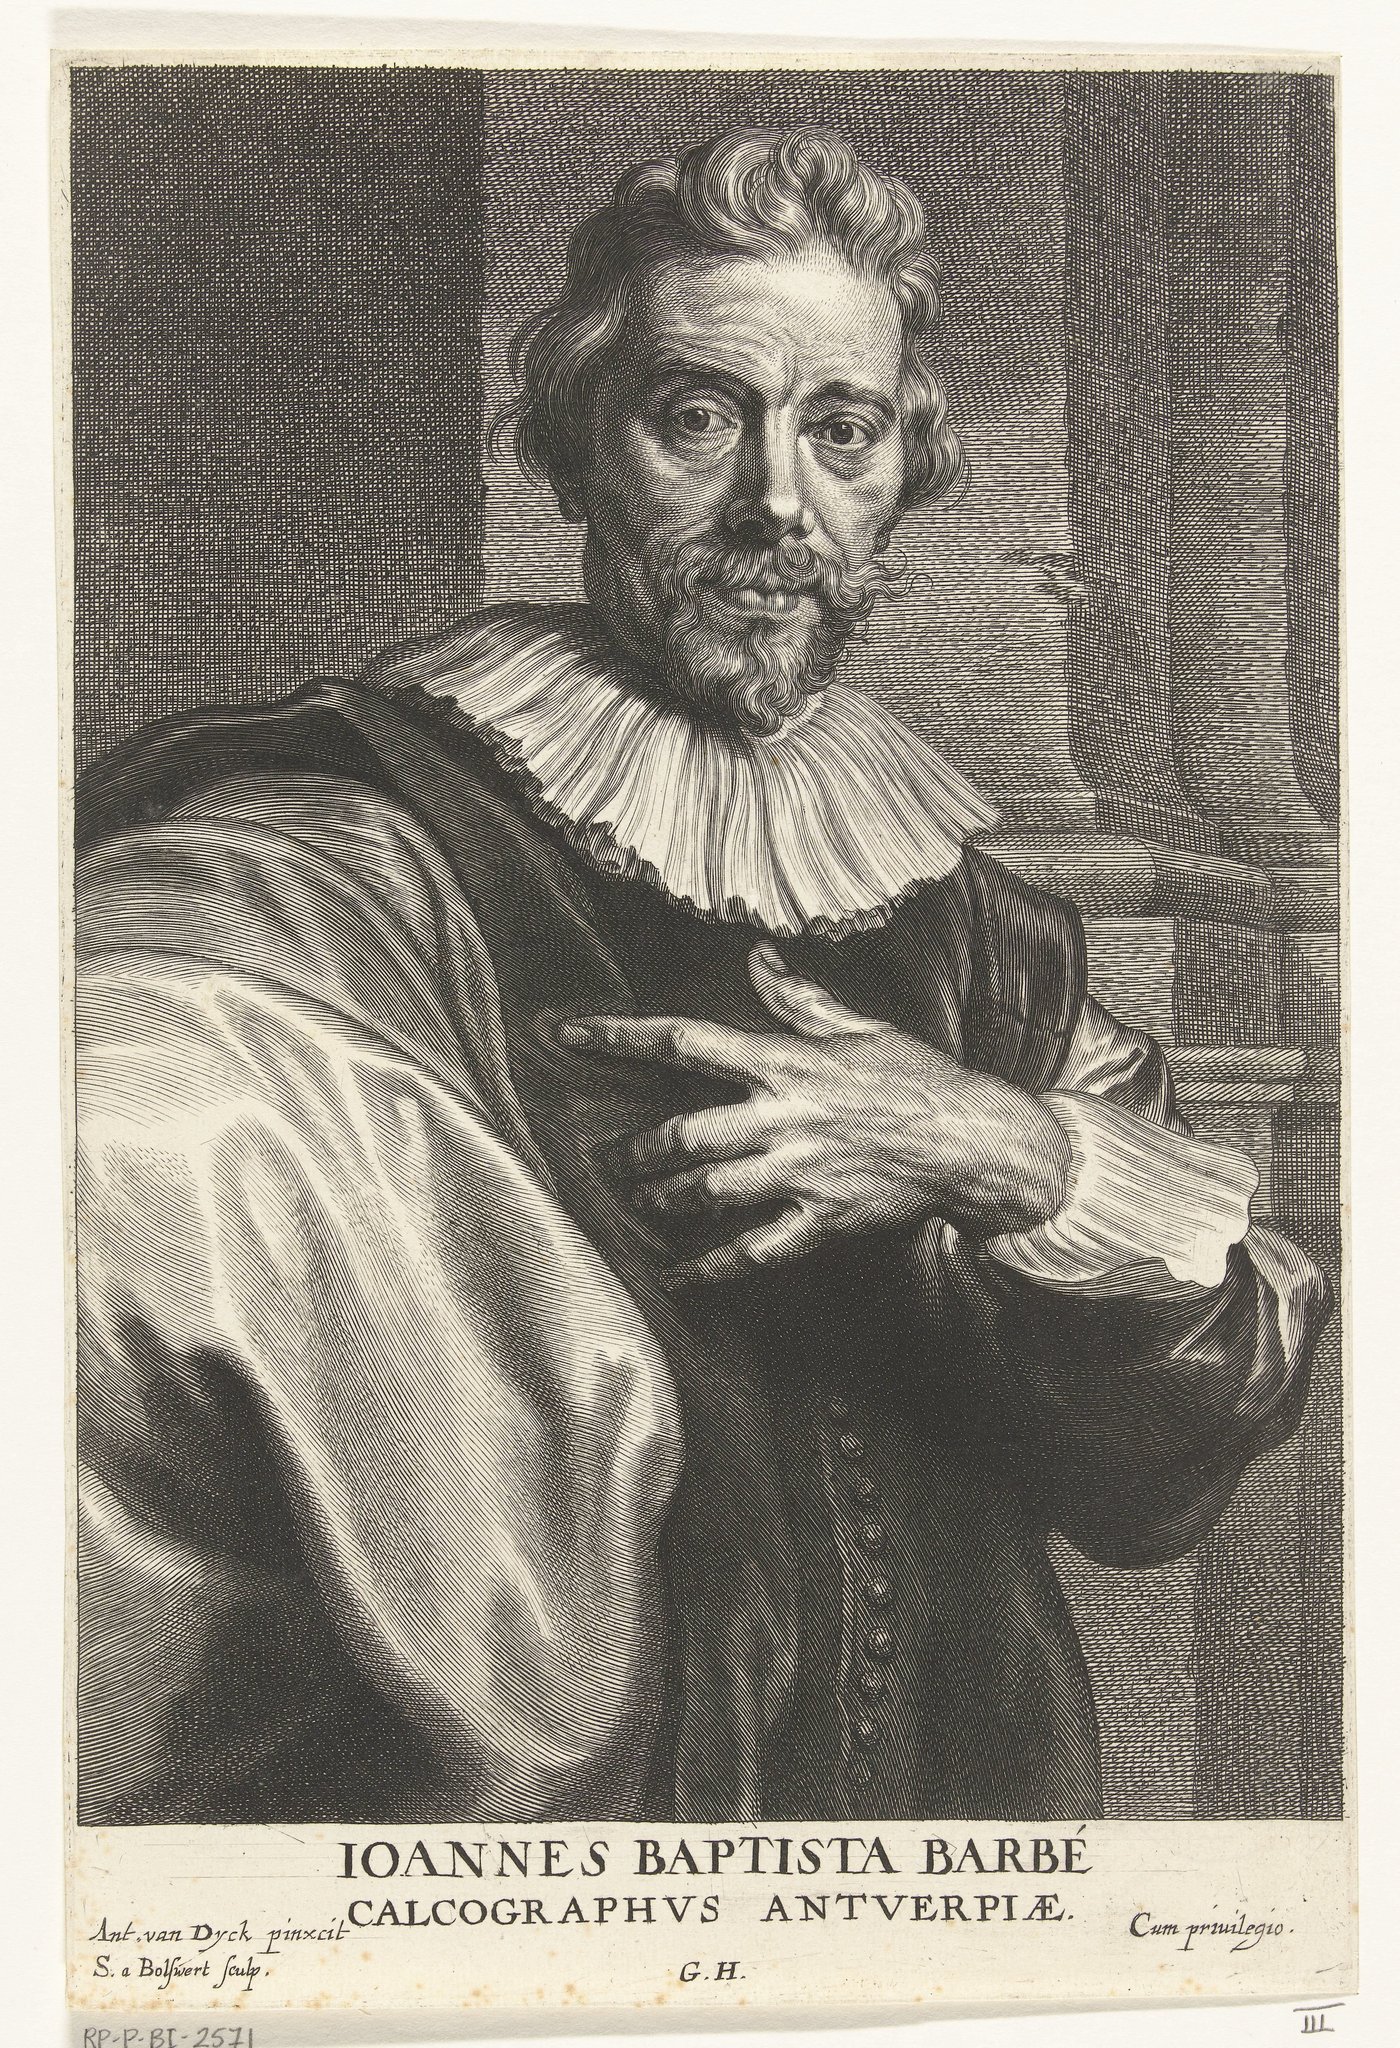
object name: print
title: Portret van graveur Jean Baptiste Barbé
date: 1596-1659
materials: paper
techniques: engraving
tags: antwerp, print maker, jan-baptist barbé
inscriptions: collector's mark: Lugt 240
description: Prent naar schilderij van Anthony van Dyck.